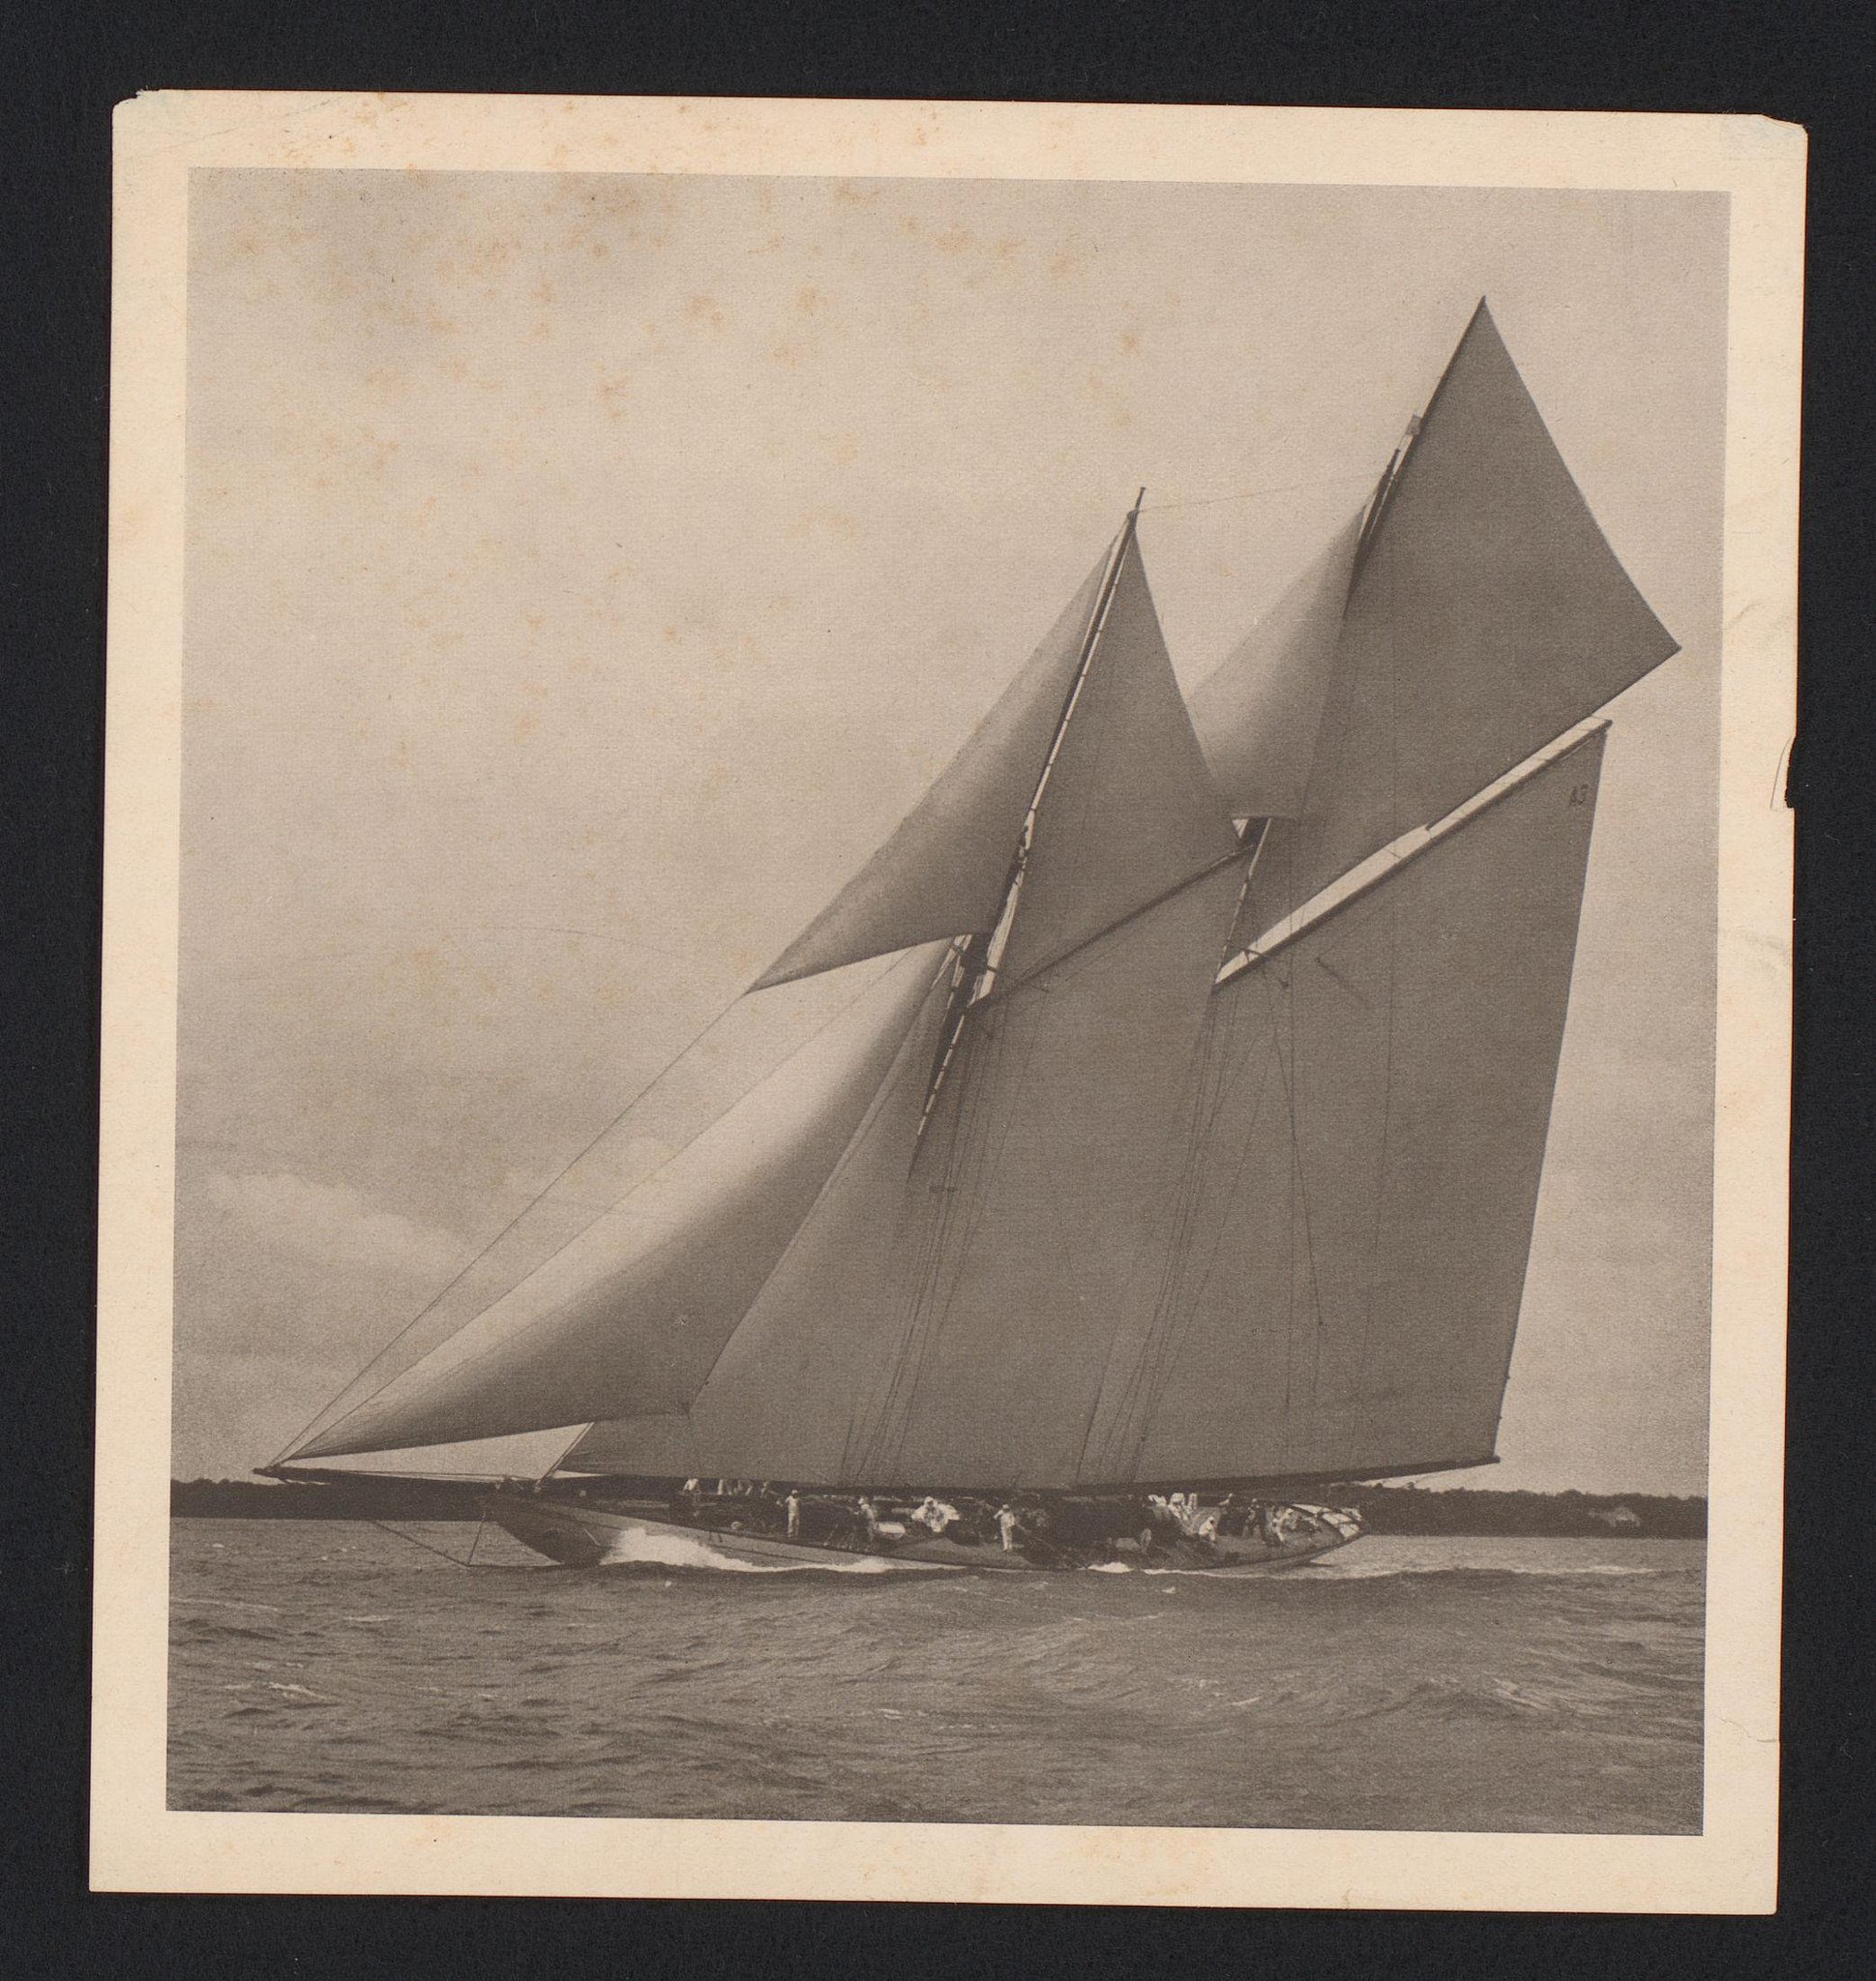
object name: photomechanical print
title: Zeilschip te water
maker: Anonymous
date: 1880-1900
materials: paper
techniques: autotype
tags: sailing-ship, sailing-boat, landscapes with waters, waterscapes, seascapes (in the temperate zone)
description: Deze prent maakt deel uit van een album.